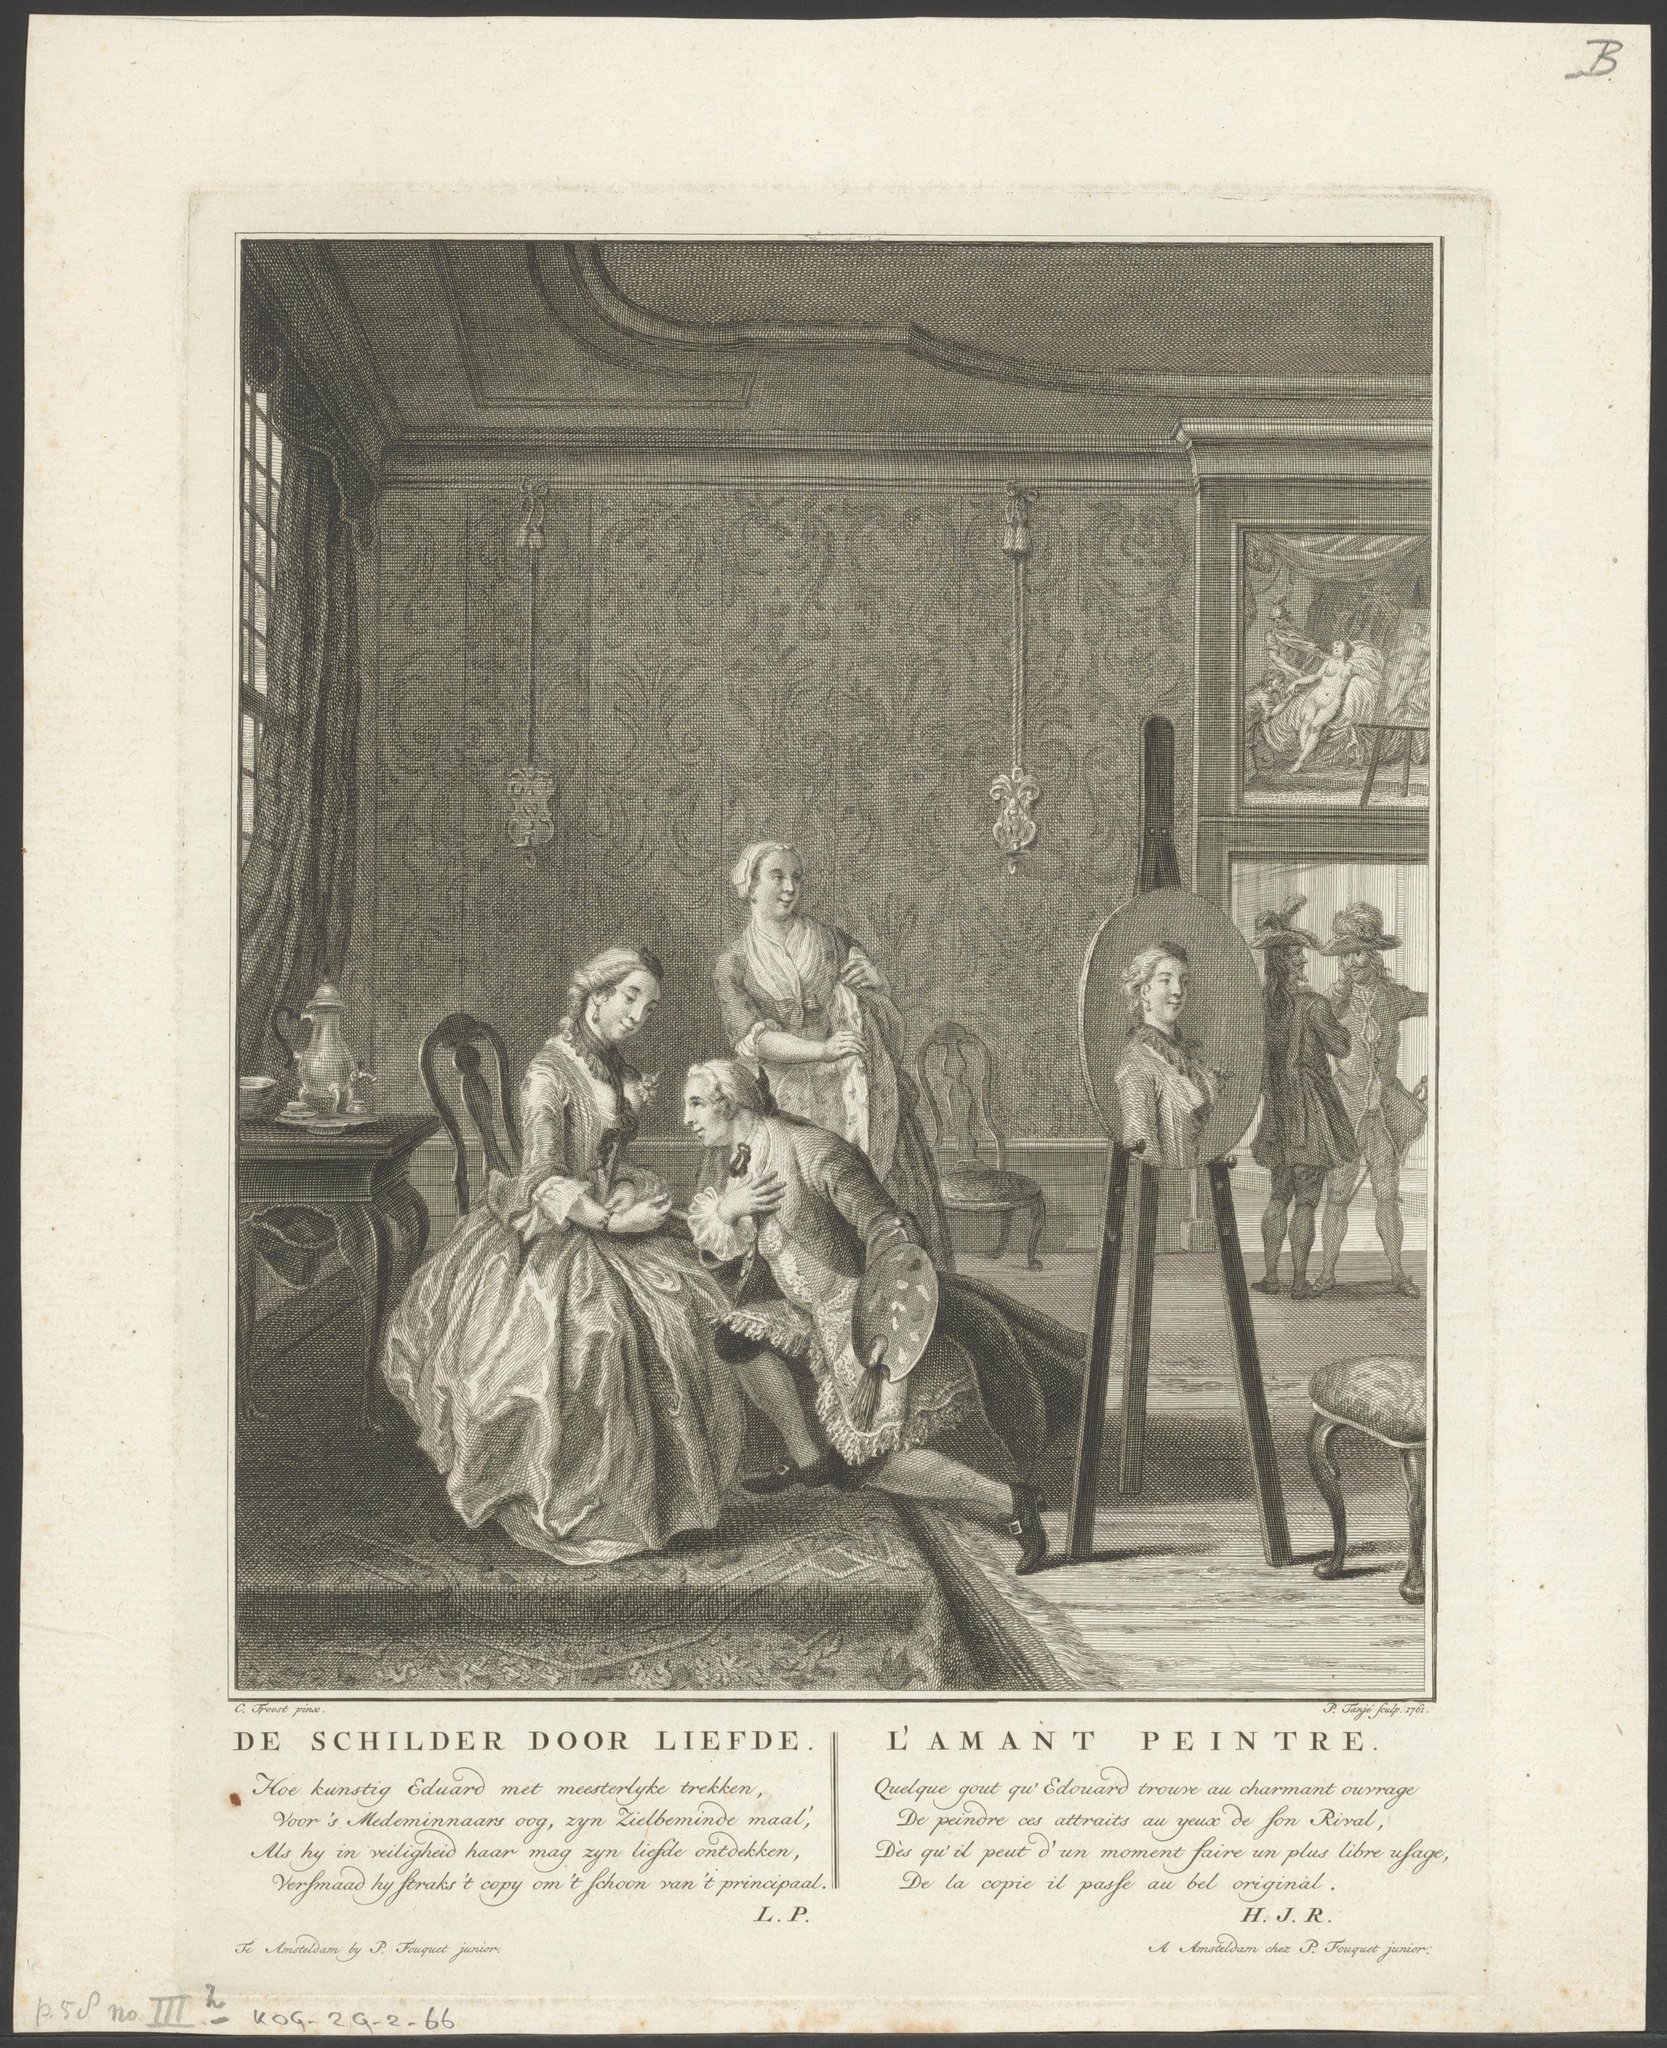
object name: print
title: De schilder door liefde / L'amant peintre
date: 1761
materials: paper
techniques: engraving, etching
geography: amsterdam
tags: kneeling figure, apelles paints campaspe and falls in love with her; alexander yields her to him, painter working from clothed model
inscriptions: collector's mark: Lugt 2488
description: De schilder Eduard verklaart Leonoor, wier portret hij vervaardigd heeft, zijn liefde. Bij de deur staat Leonoors jaloerse man Don Pedro, die door de schildersknecht bezig wordt gehouden. Boven de deur hangt een schilderij met een voorstelling van Alexander, die de schilder Apelles zijn minnares Campaspe ten geschenke geeft. Onderaan in de marge vierregelige verzen in het Nederlands en het Frans. Scène uit het tweede bedrijf van het toneelstuk De schilder door liefde, van Molière.